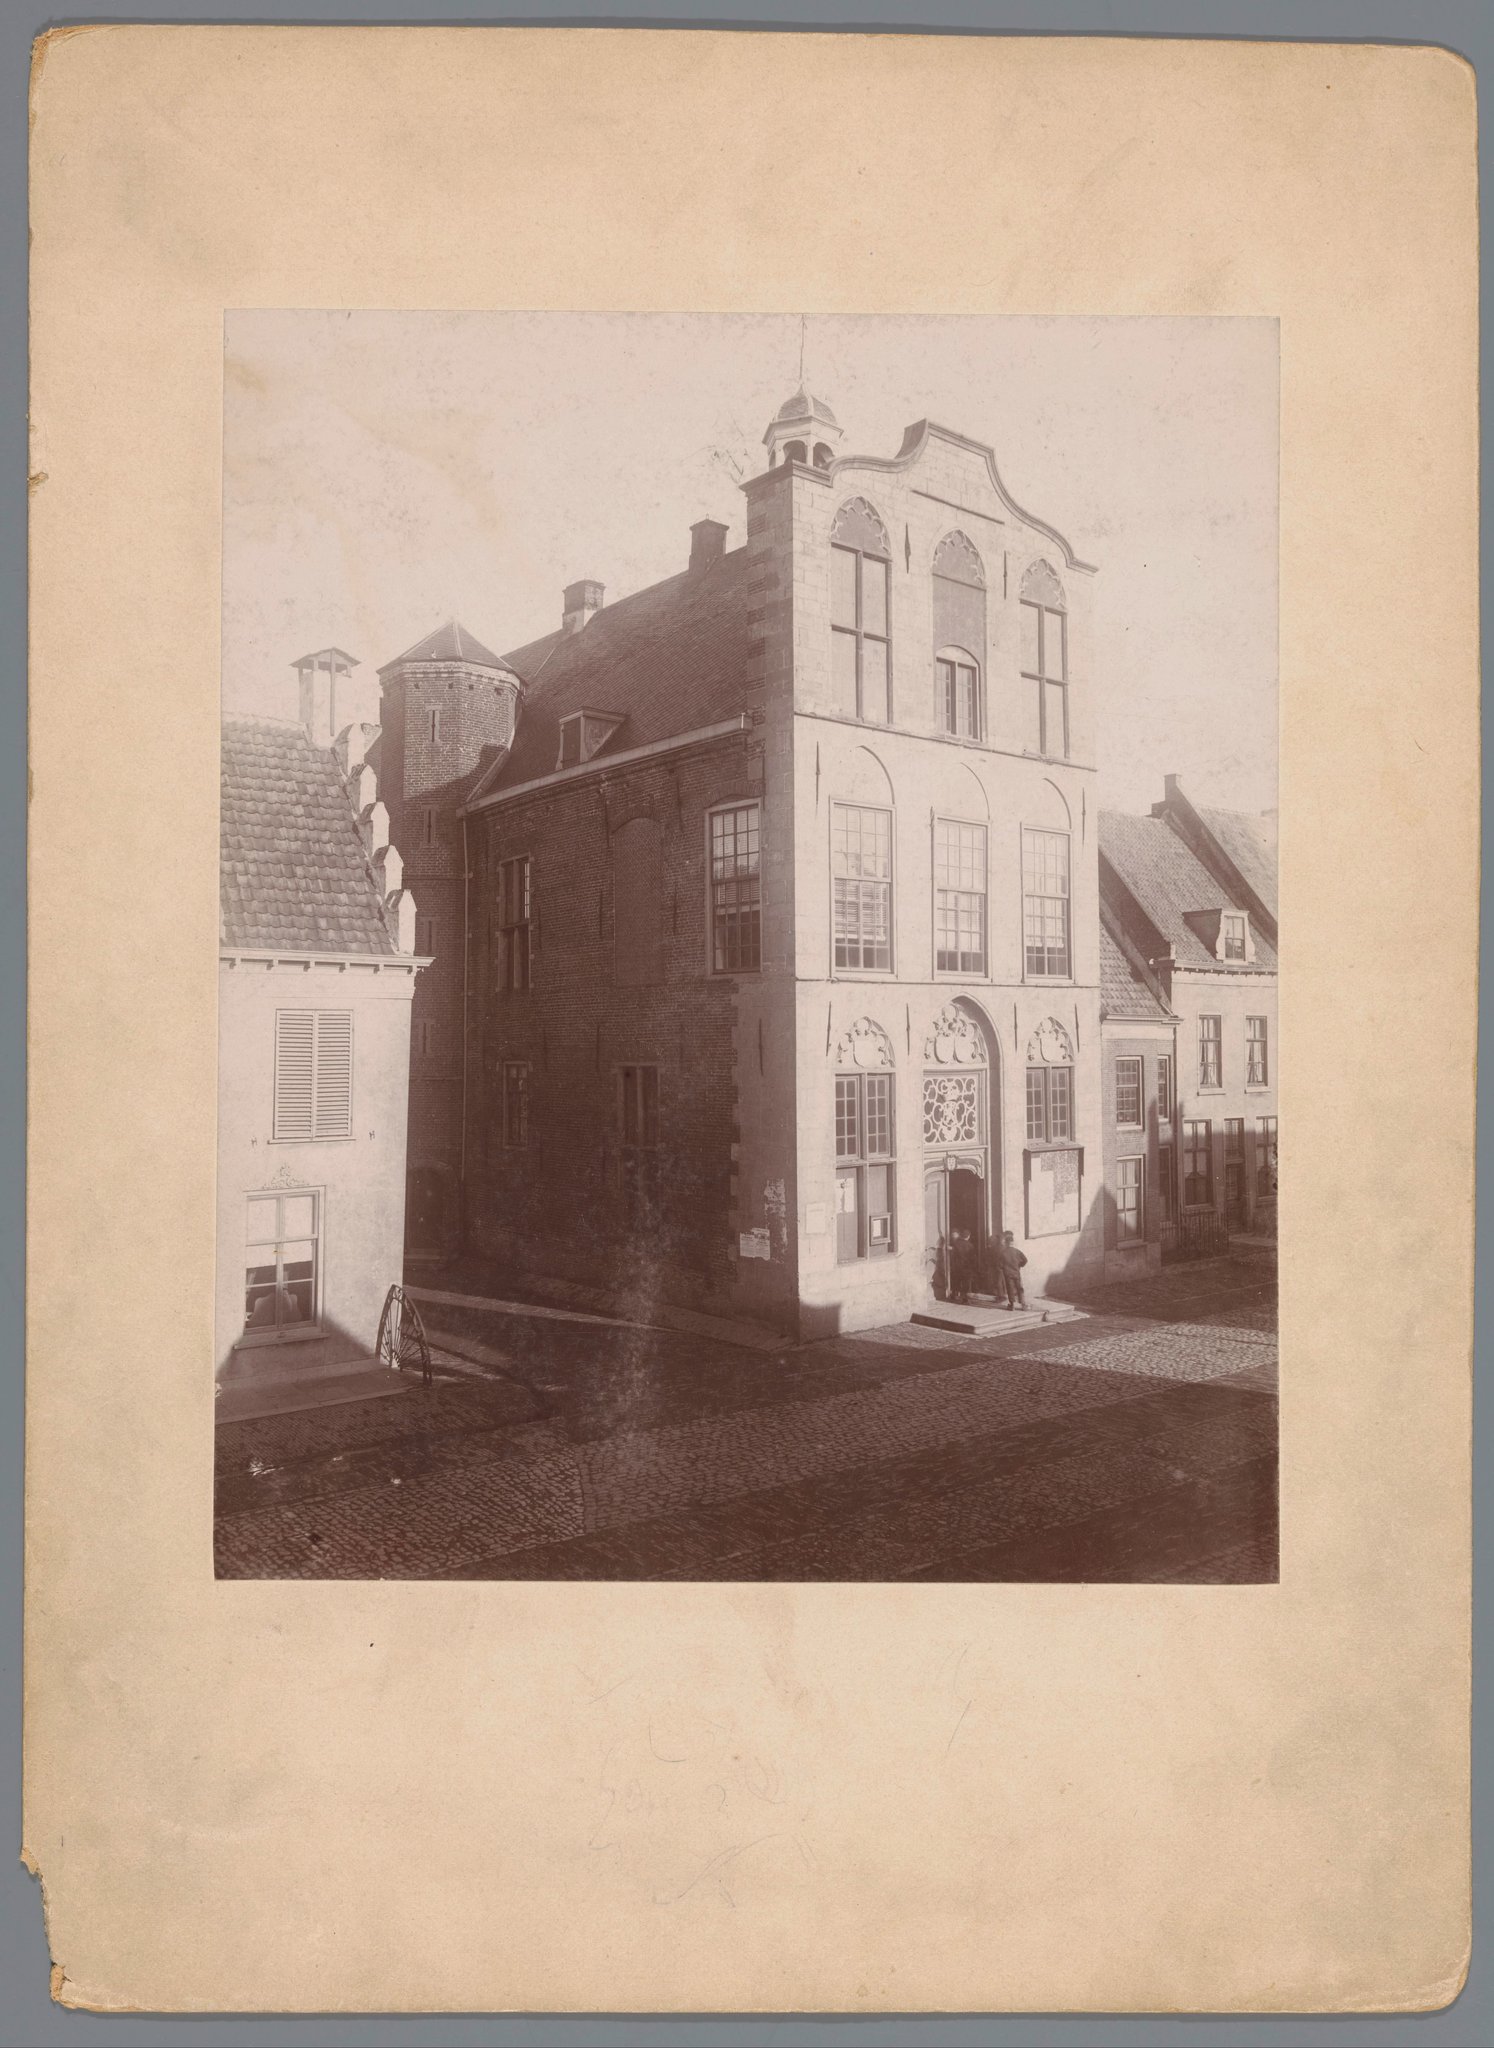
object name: photograph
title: Exterieur van het stadhuis van Vianen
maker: Anonymous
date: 1875-1900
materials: cardboard, photographic support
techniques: daylight paper print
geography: vianen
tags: townhall, façade (of house or building), prospect of city, town panorama, silhouette of city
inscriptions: collector's mark: Lugt 3937, annotation:, inscription: ‘Vianen Raadhuis’